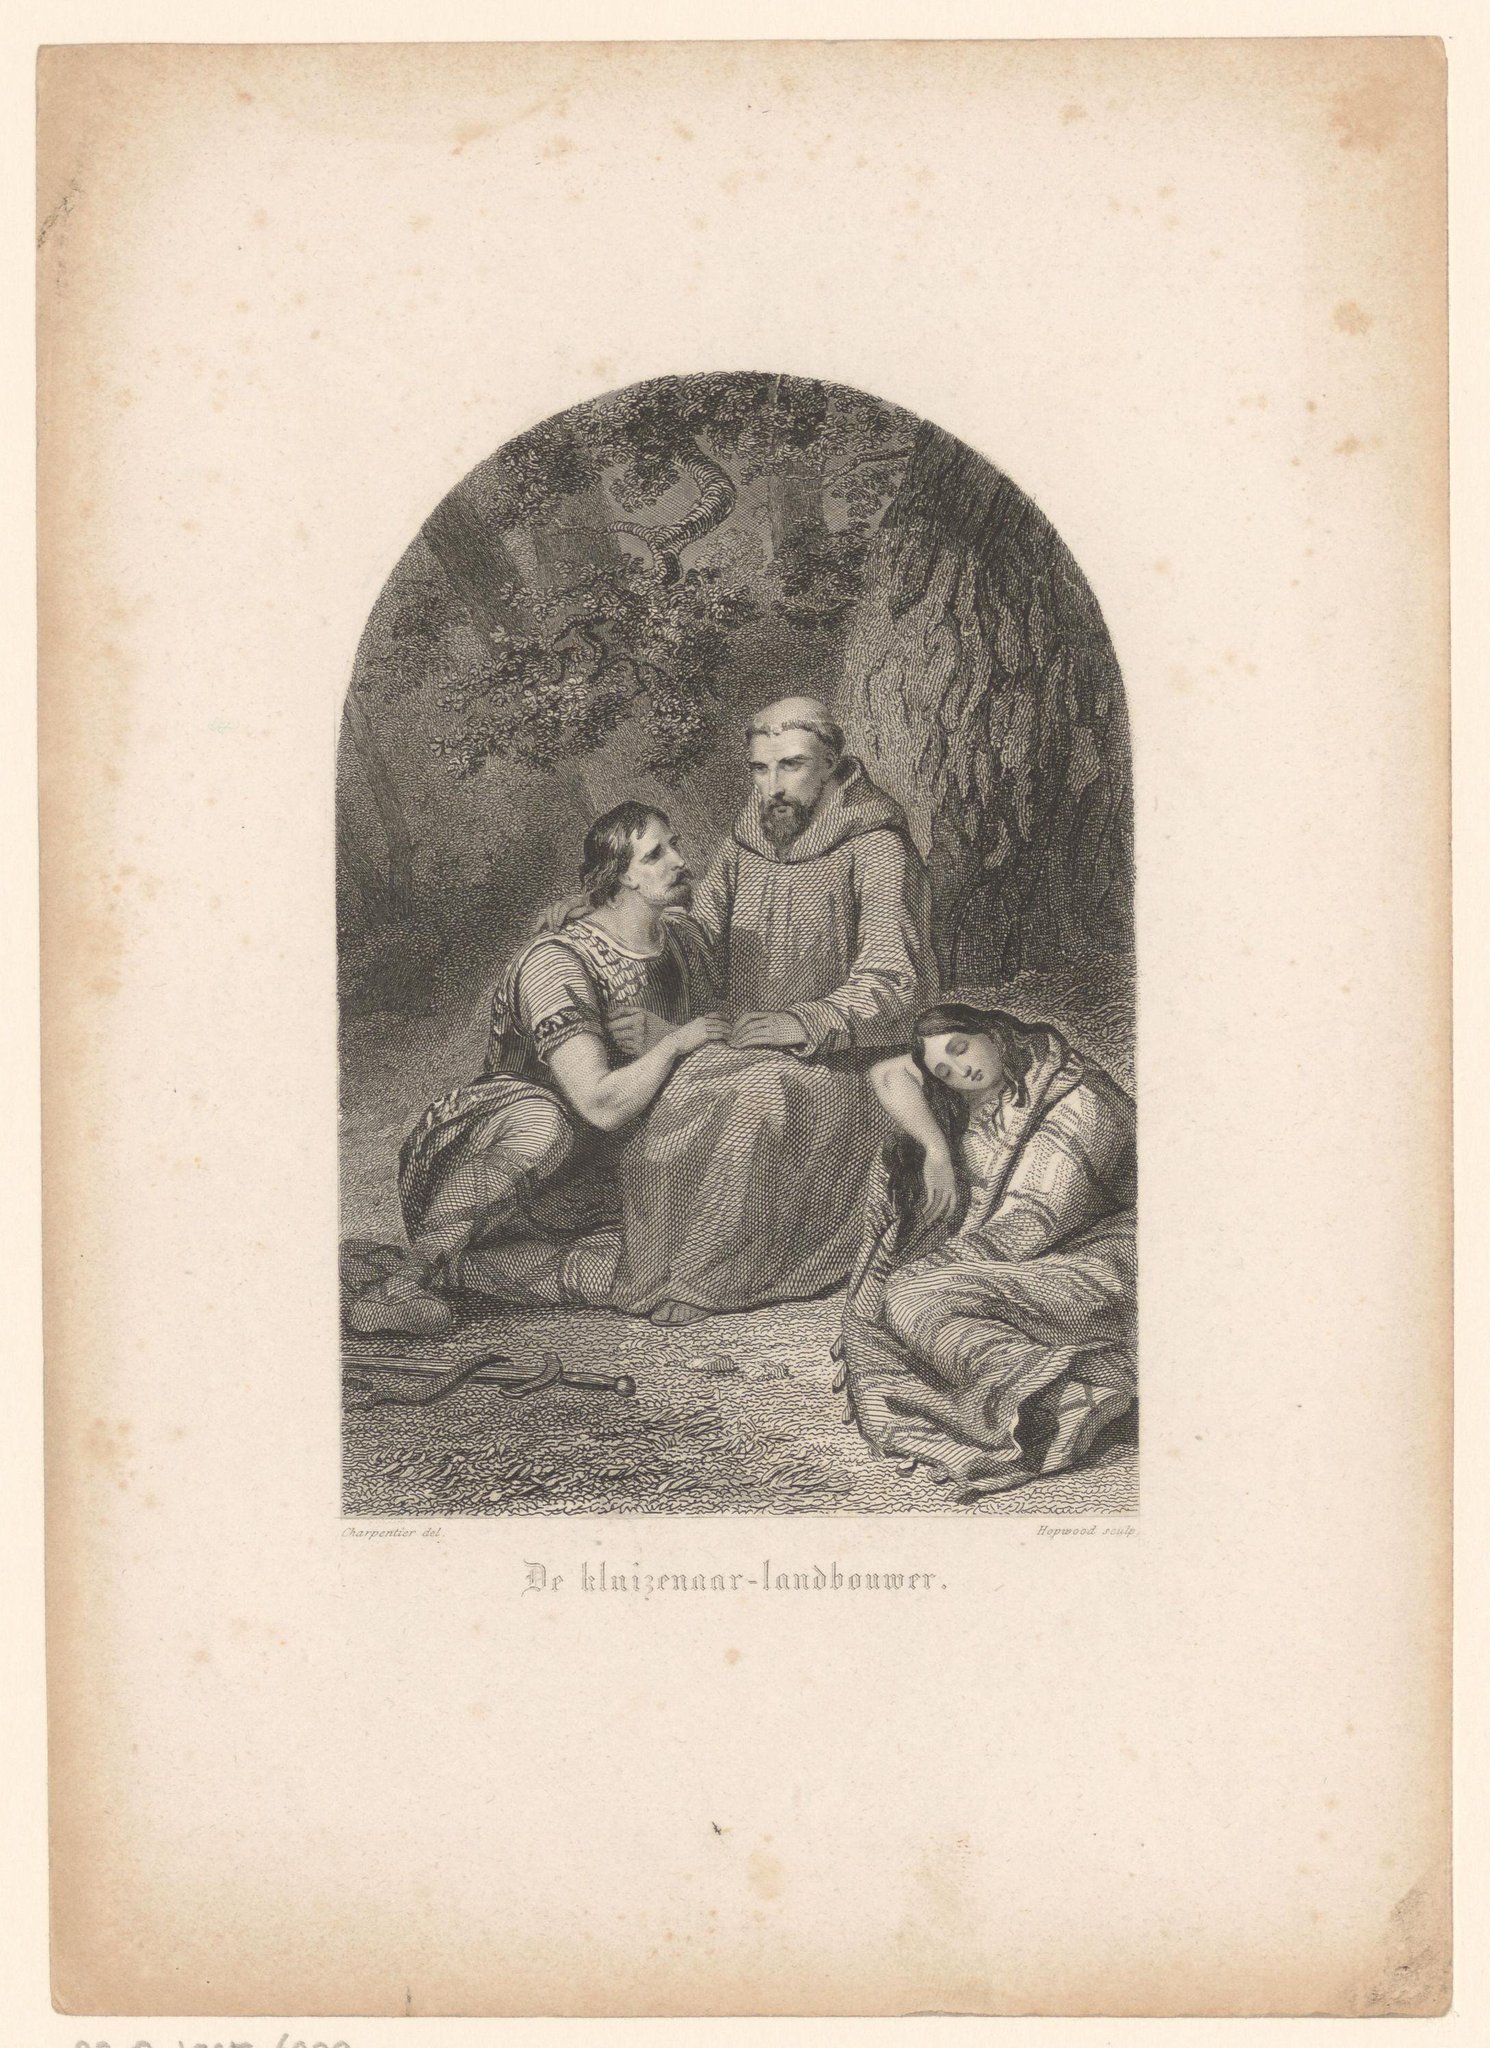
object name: print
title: De kluizenaar-landbouwer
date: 1851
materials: paper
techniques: etching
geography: amsterdam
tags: sleeping on the ground - bb - out of doors, monk(s), friar(s)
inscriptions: collector's mark: Lugt 2228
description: Prent uit: Sue, Eugène. De Verborgenheden des Volks, of geschiedenis van een Arbeiders-geslacht, door de eeuwen heen. Amsterdam: M.H. Binger en Zonen, 1851, dl. 4, tussen p. 70 en 71.